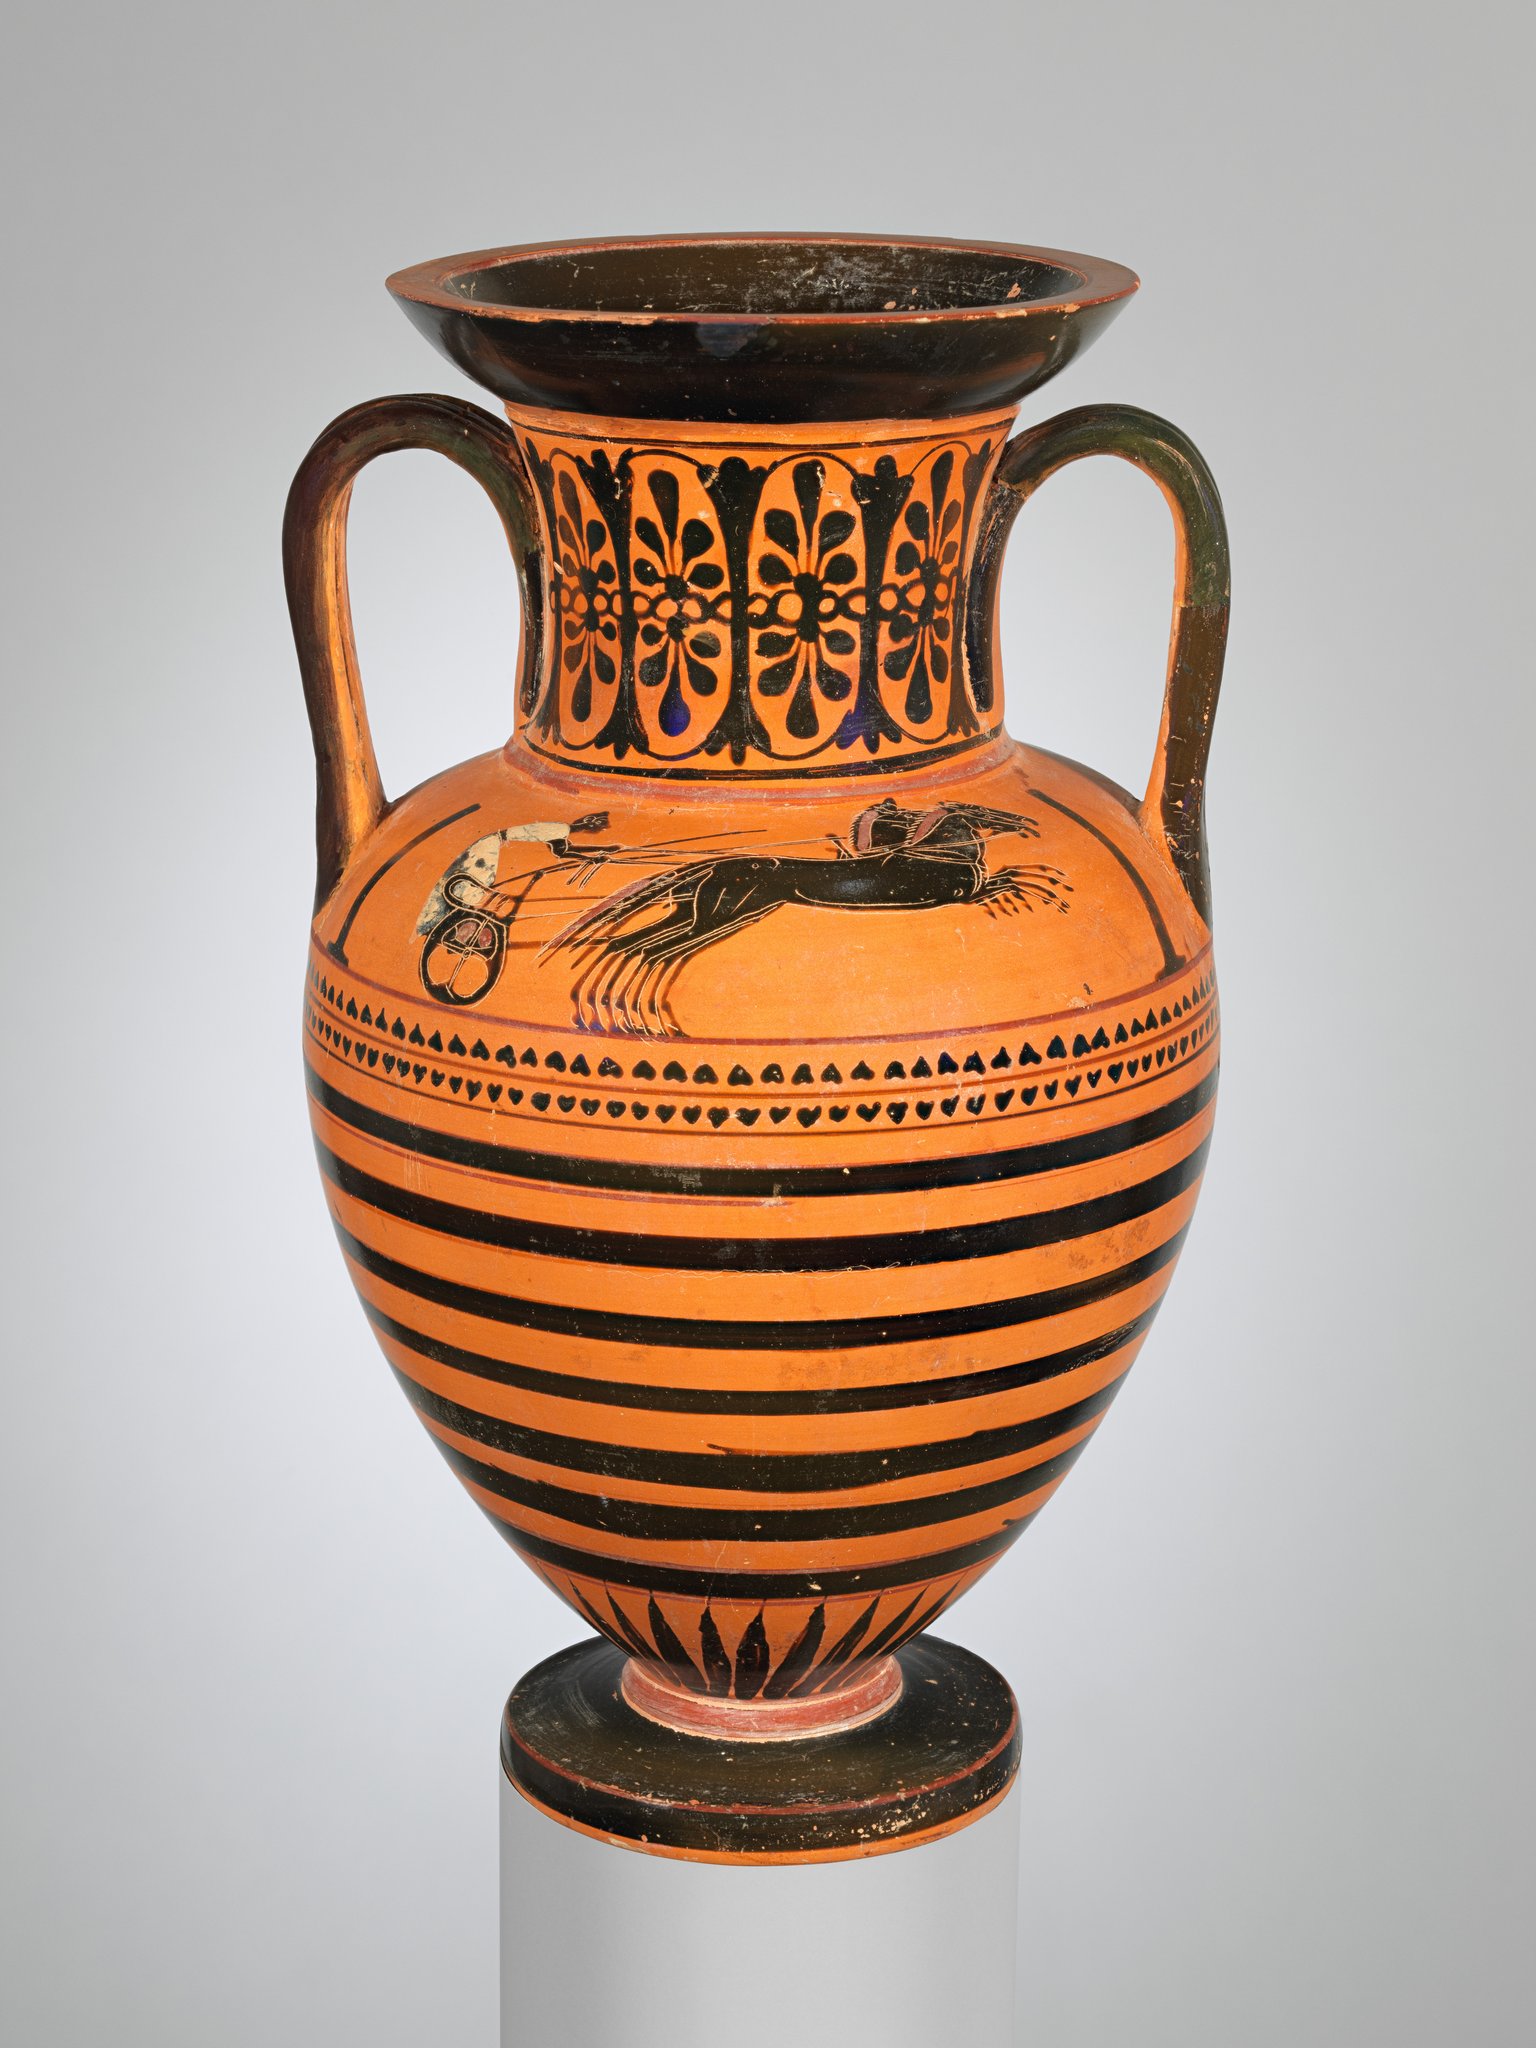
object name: neck amphora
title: Terracotta neck-amphora (jar)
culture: greek, attic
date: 500 BCE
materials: terracotta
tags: horses,chariots